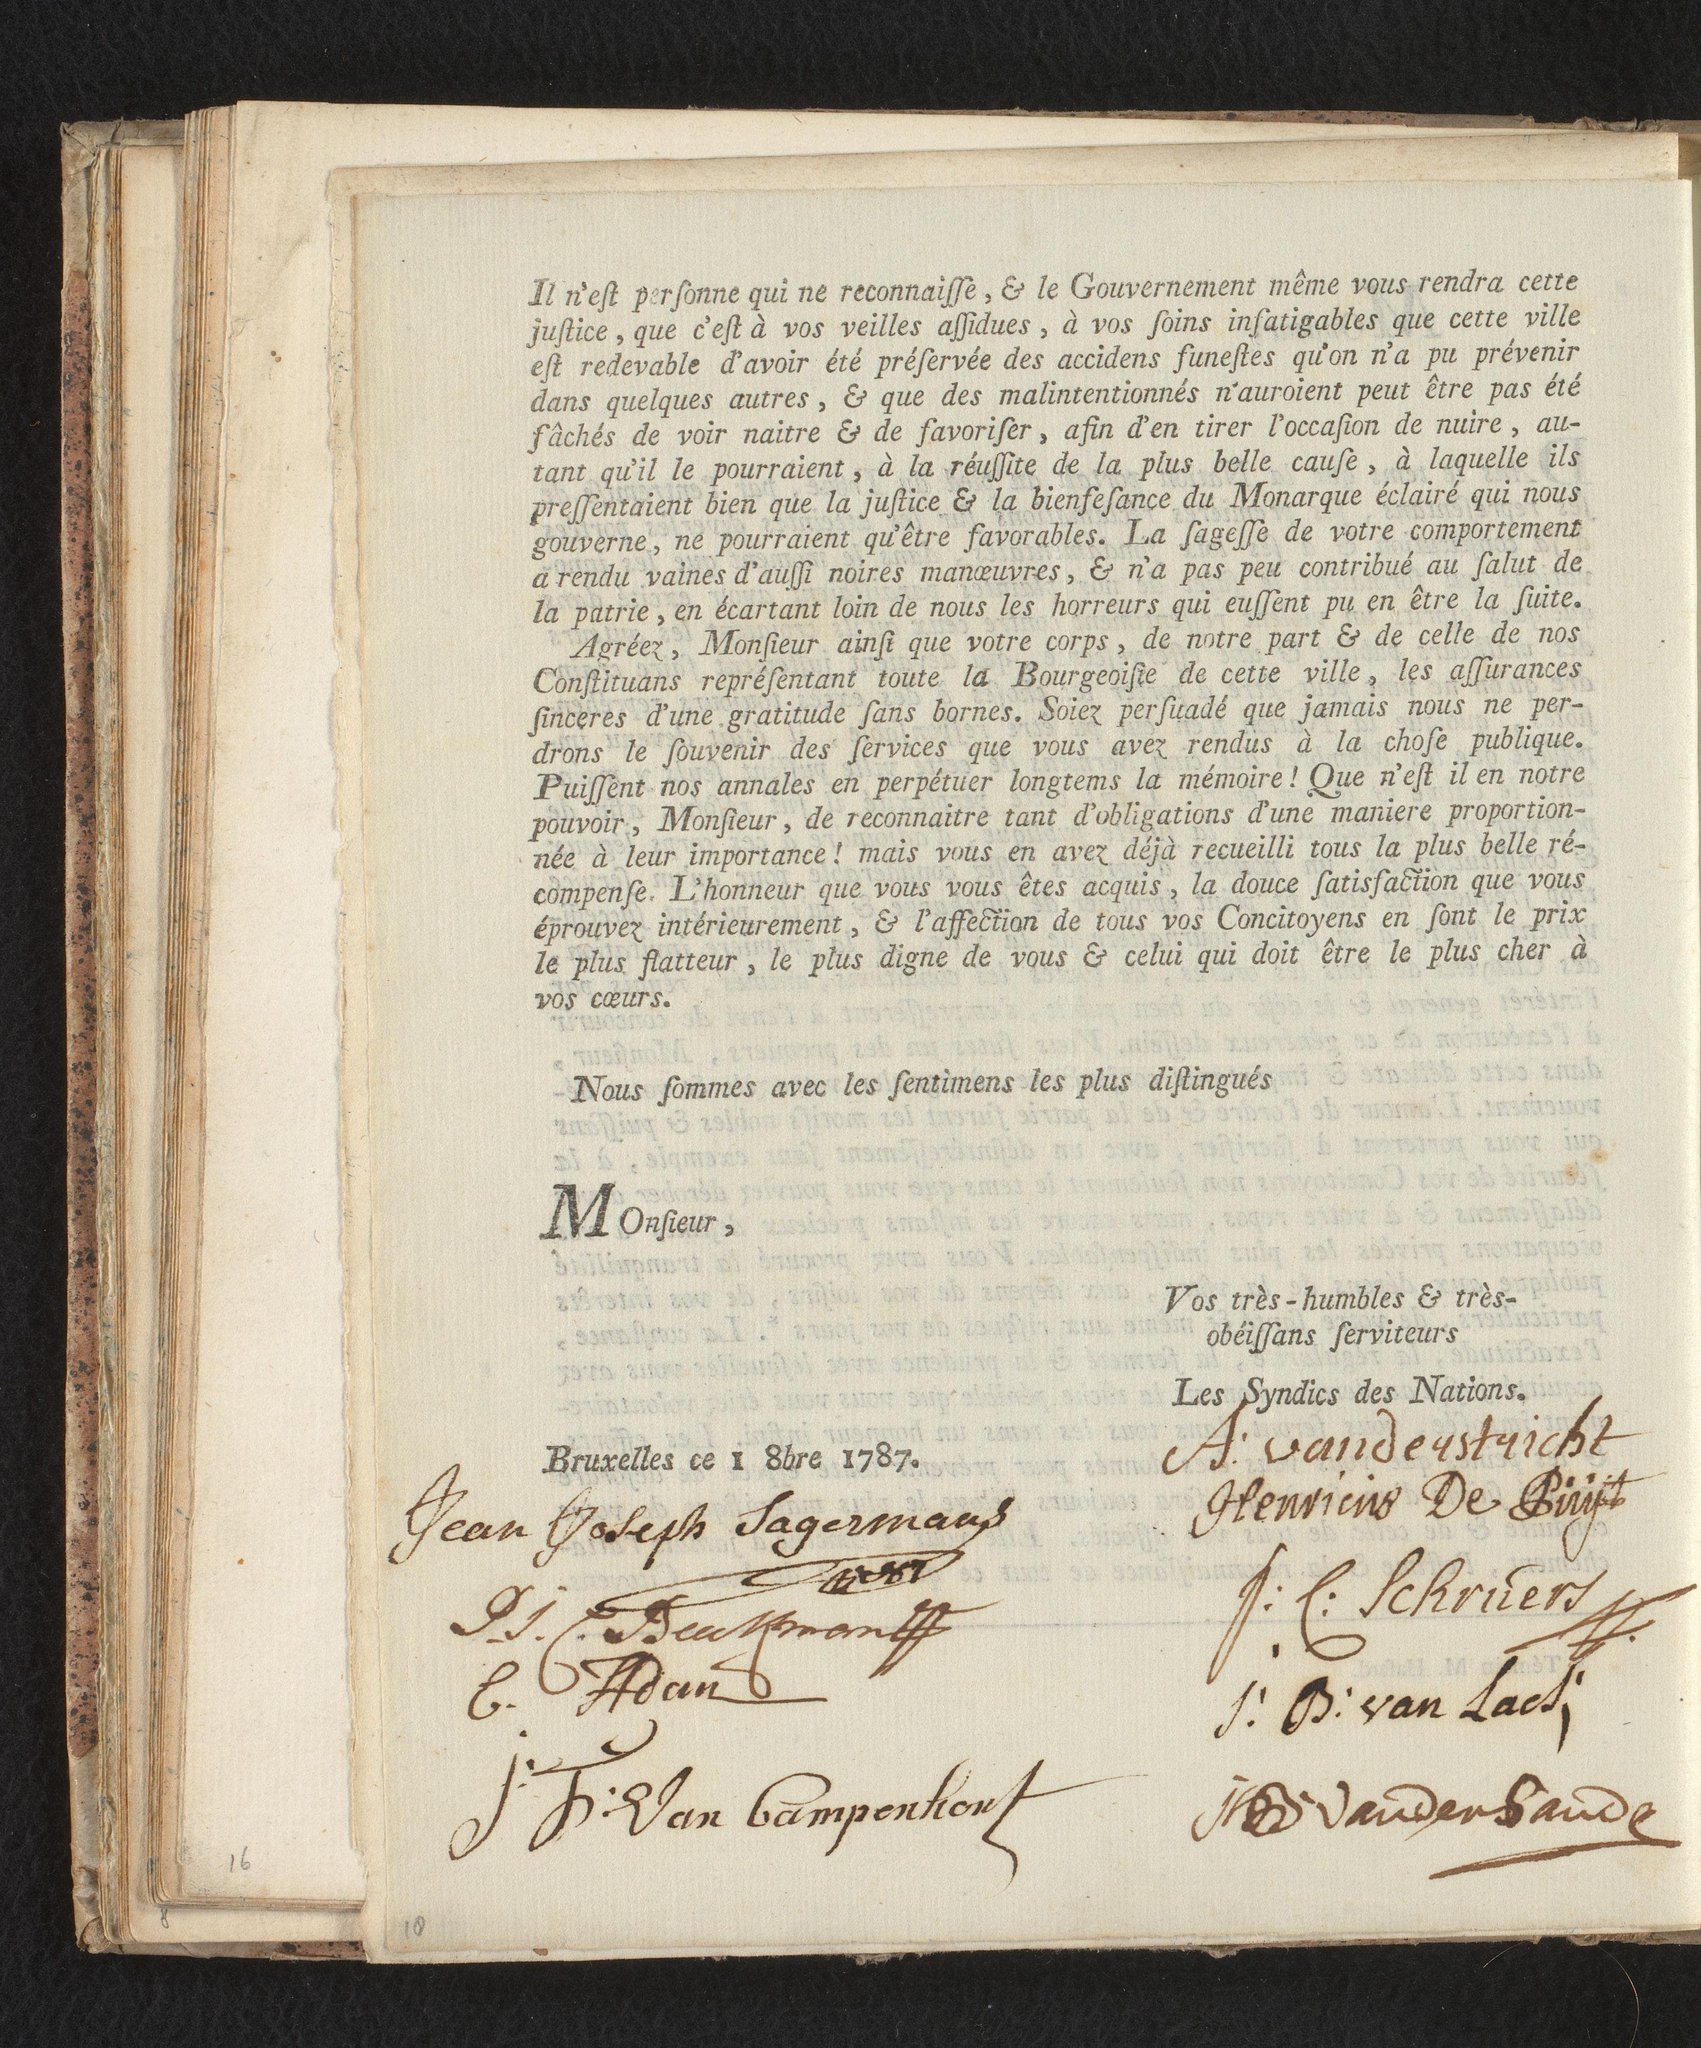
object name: text sheet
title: Gedrukte brief van 1787 (achterzijde)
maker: Anonymous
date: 1787-1790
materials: paper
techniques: letterpress printing, writing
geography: brussels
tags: brussels, brabant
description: Achterzijde van een gedrukte brief van 1 augustus 1787 ondertekend door de acht vertegenwoordigers. Onderdeel van de gebundelde verzameling prenten betrekking hebbend op de gebeurtenissen van de Brabantse Omwenteling en de periode 1787-1790.